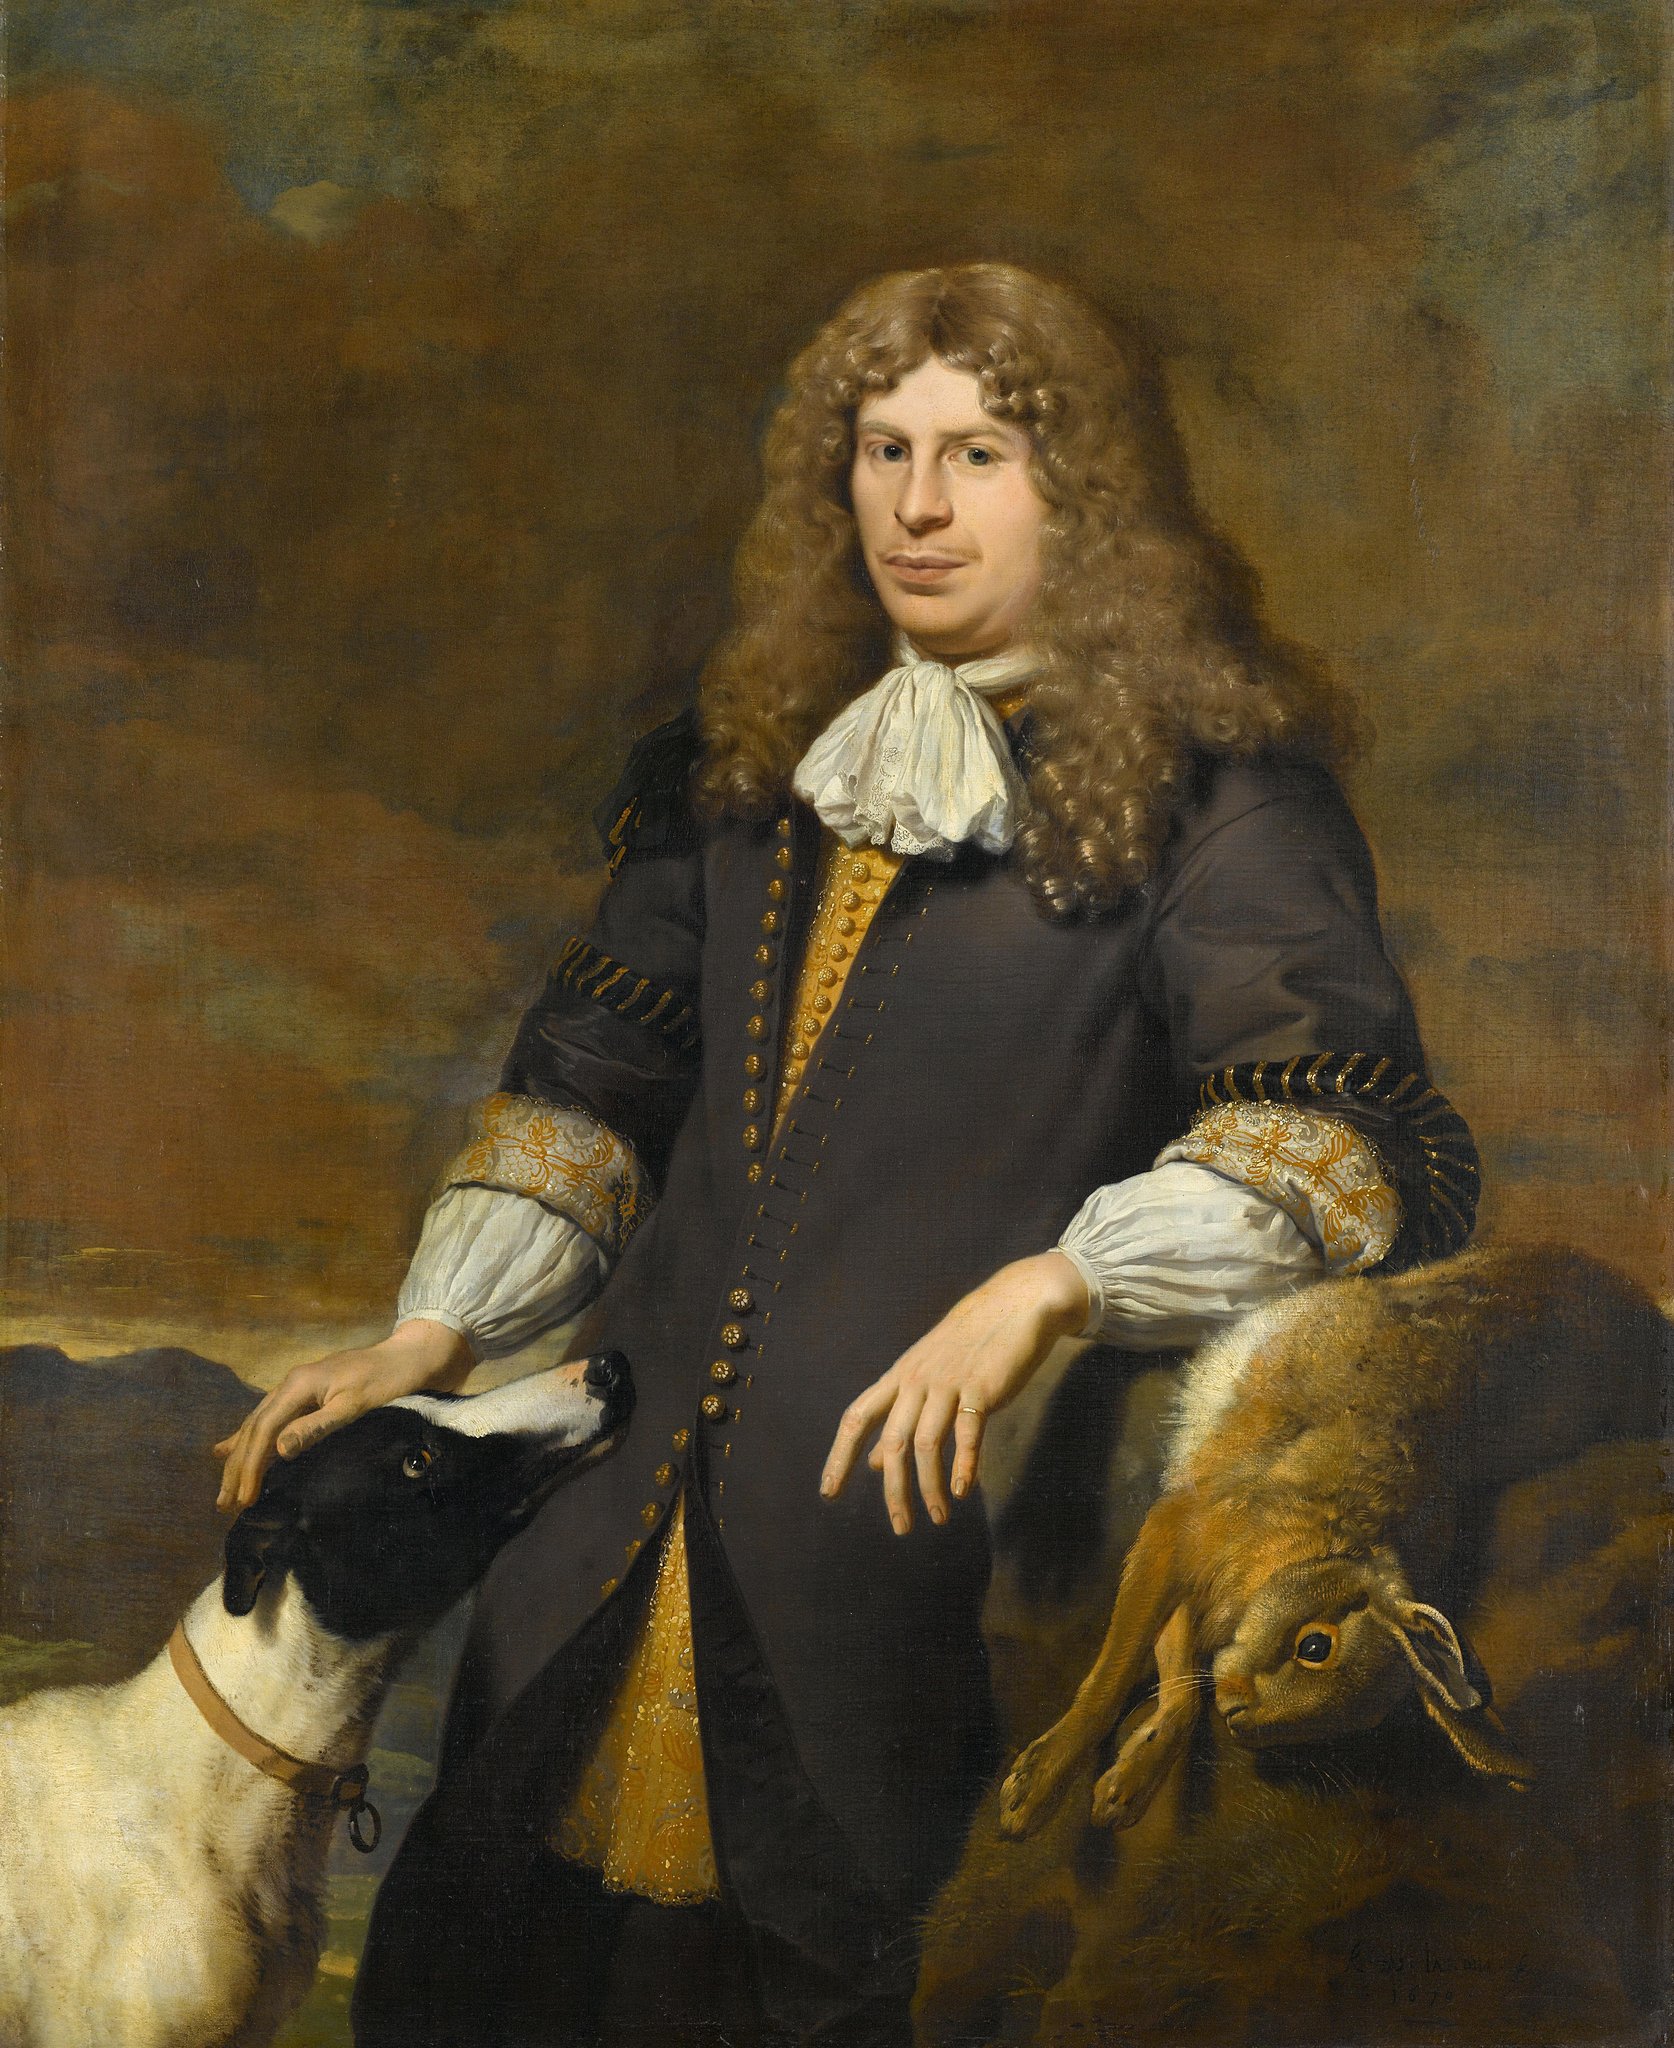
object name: painting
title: Portrait of a Man, possibly Jacob de Graeff, Alderman of Amsterdam in 1672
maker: karel du jardin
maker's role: draughtsman, painter, print maker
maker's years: 1626-1678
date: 1670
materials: canvas, oil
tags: historical persons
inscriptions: signature and date: ‘K. du Iardin. fe 1670.’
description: Portret van een man, mogelijk Jacob de Graeff, schepen van Amsterdam in 1672. Kniestuk, leunend tegen een rots, de rechterhand rust op de kop van een windhond, rechts een dode haas.